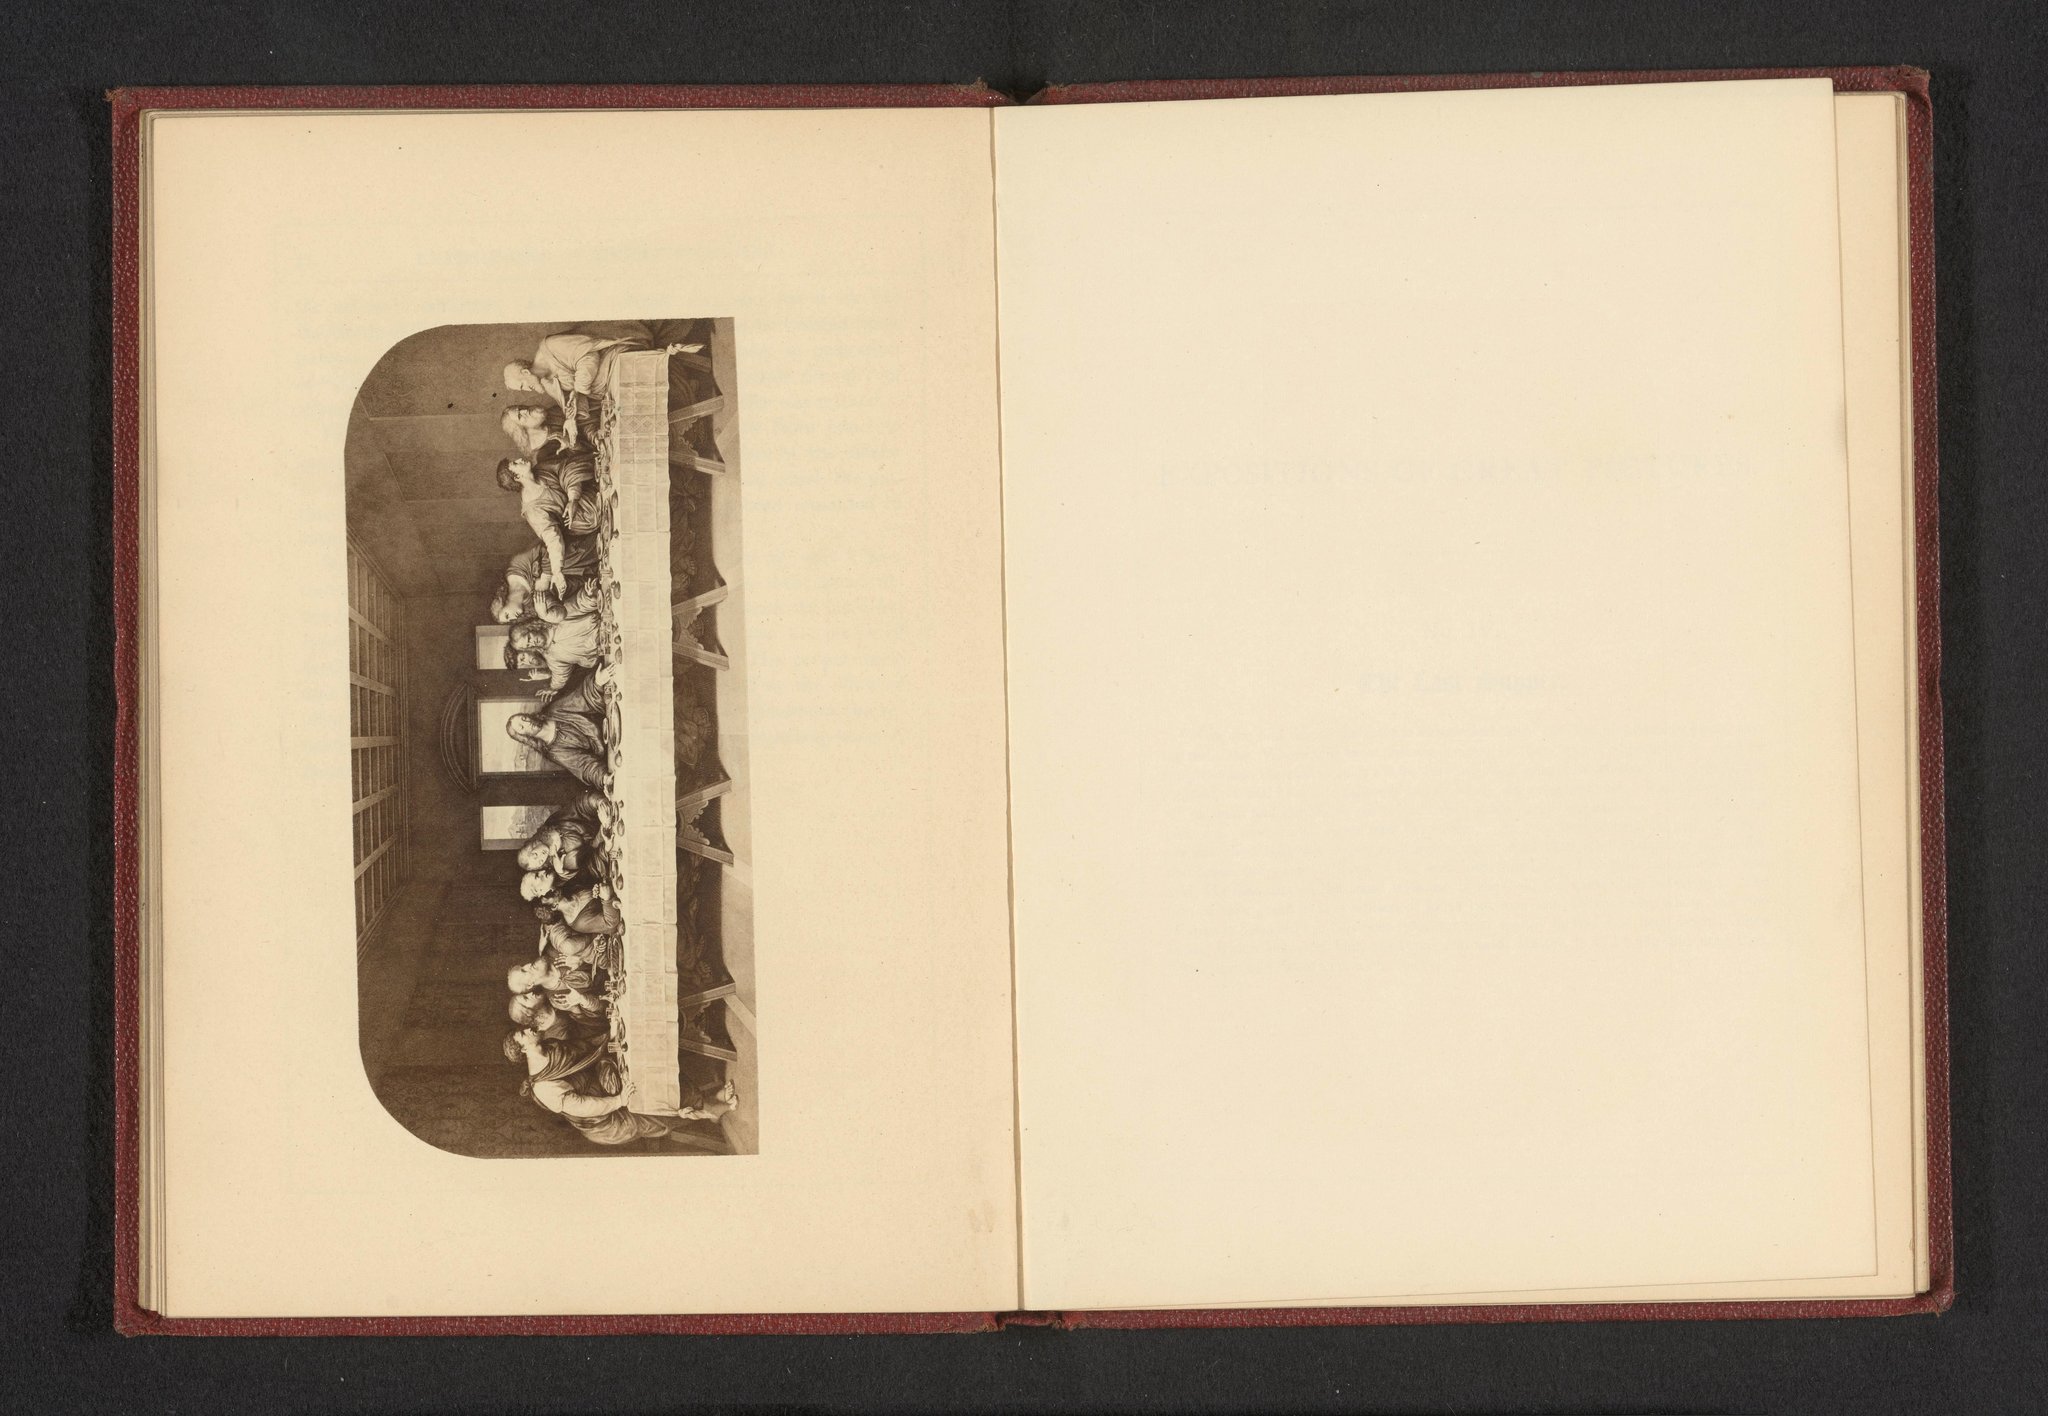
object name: photograph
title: Fotoreproductie van een prent naar een schilderij, voorstellende het Laatste Avondmaal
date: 1853-1863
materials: photographic support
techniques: albumen print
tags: the episode of the last supper